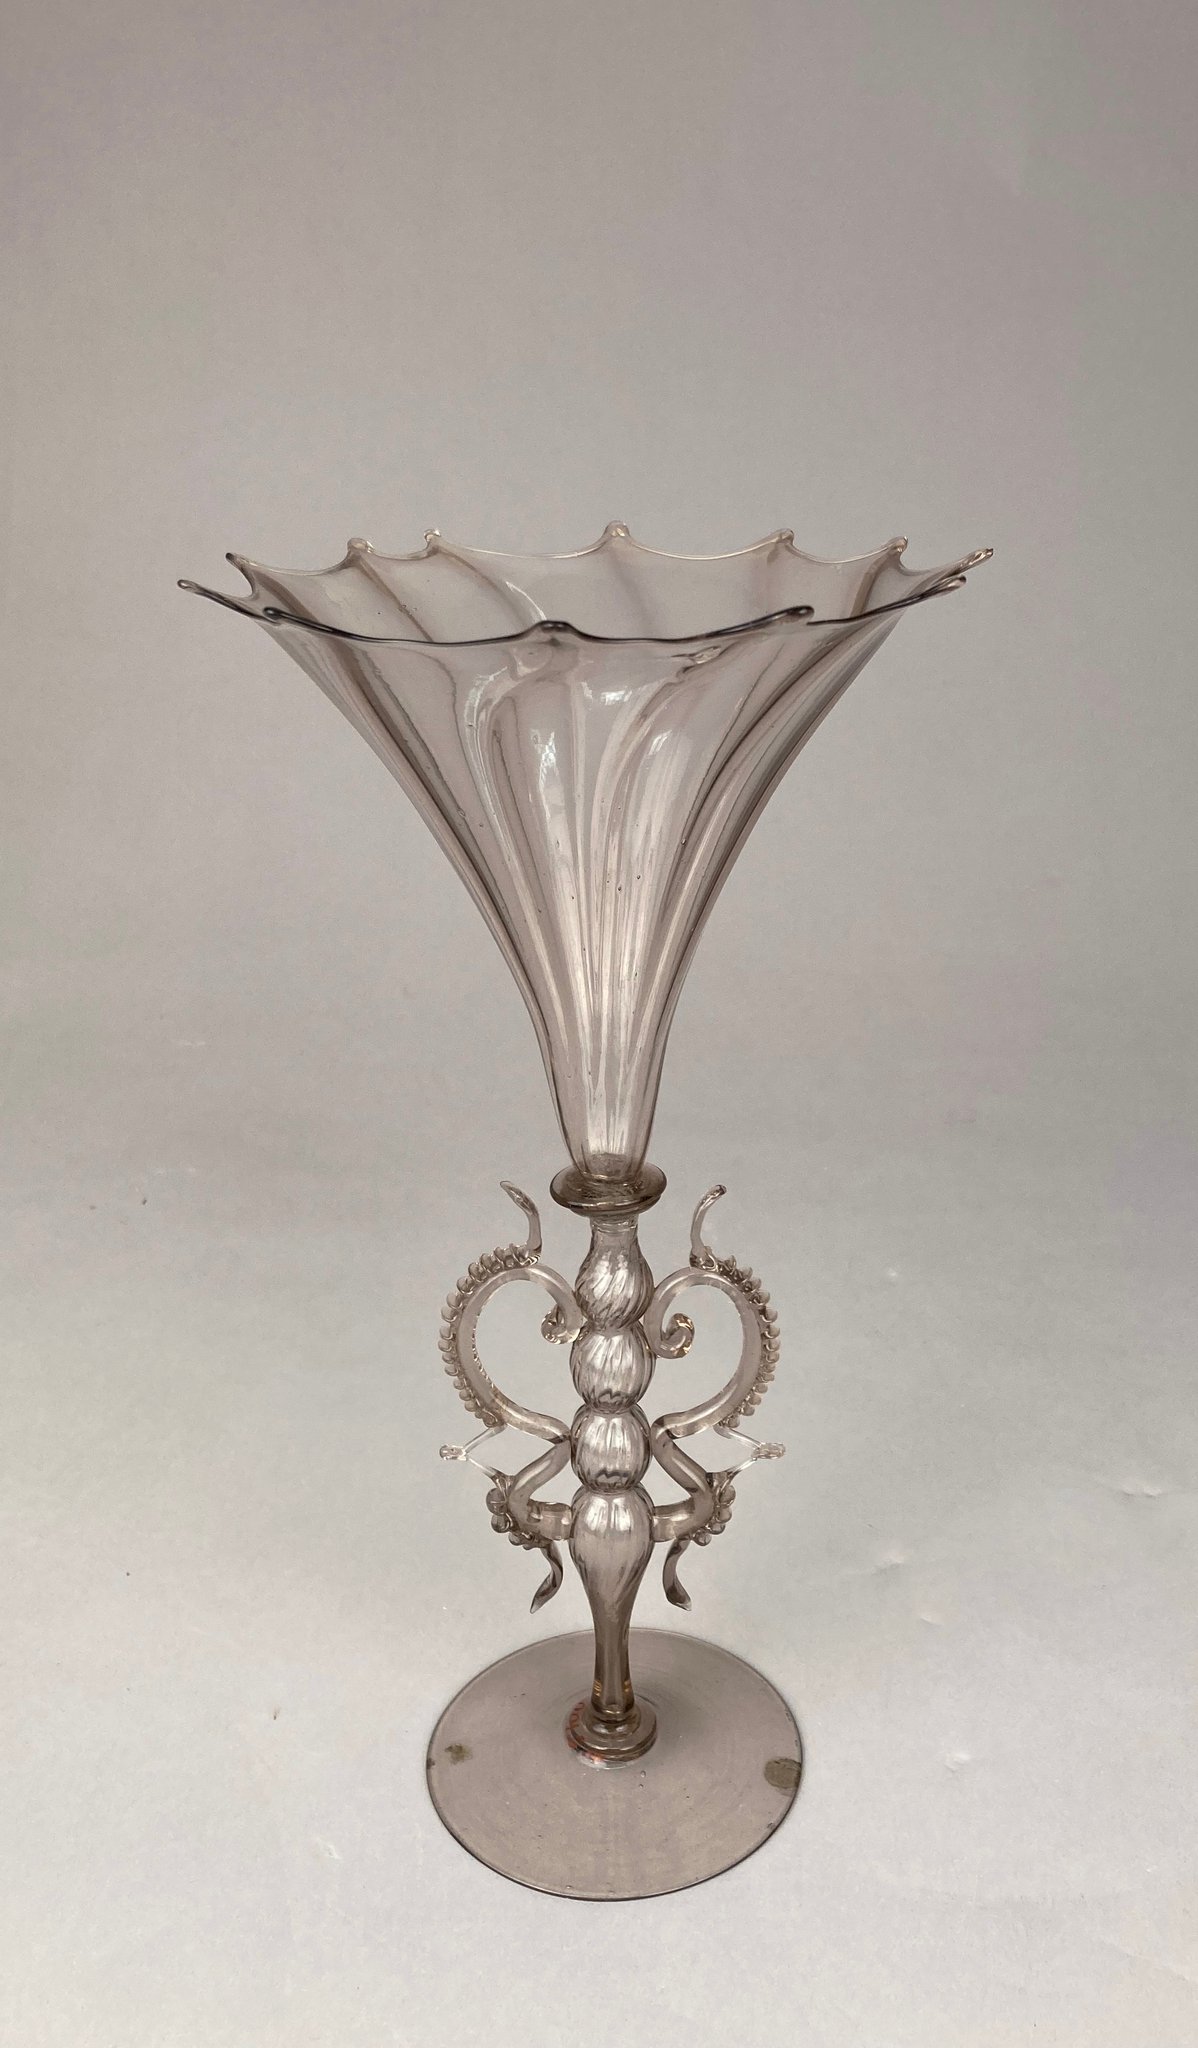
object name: goblet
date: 1801-1900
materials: glass